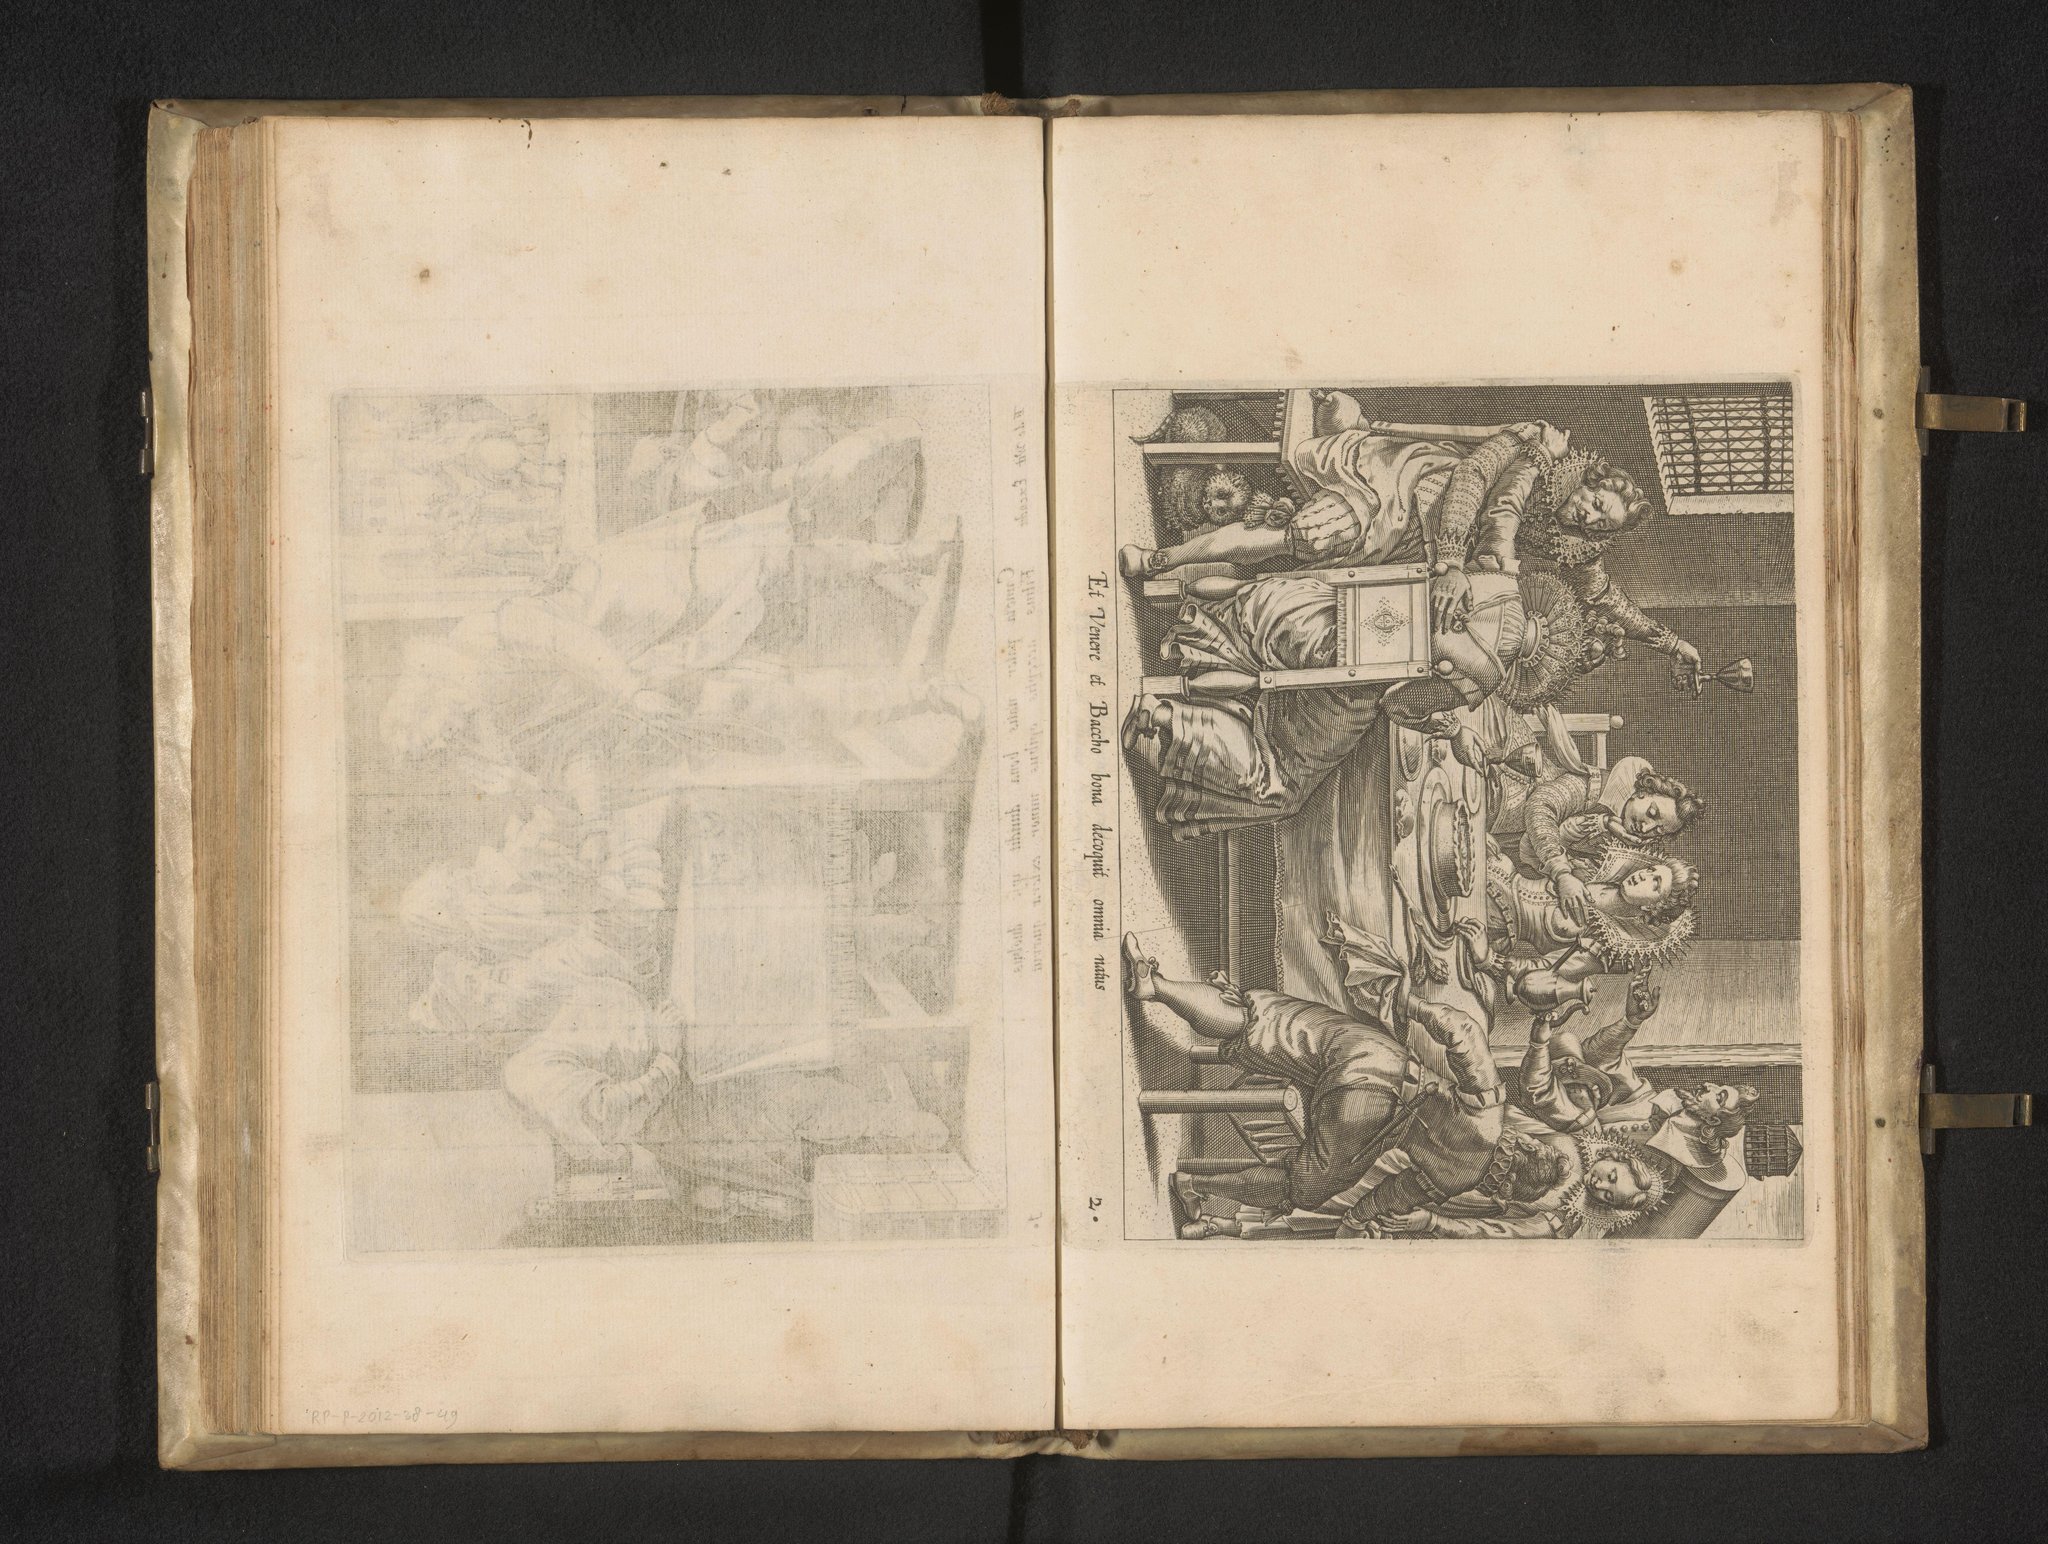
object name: print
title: Het losbandige leven van de verloren zoon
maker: frederik de wit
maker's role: print maker, printer, publisher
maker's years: 1629-1706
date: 1648-1706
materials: paper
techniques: engraving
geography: amsterdam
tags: the prodigal son in the midst of prostitutes feasting and dissipating his patrimony, usually in a brothel or inn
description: Het losbandige leven van de verloren zoon. Onderdeel van een serie van 4 prenten van het verhaal van de Verloren Zoon. Genummerd rechtsonder: 2. In de marge een regel tekst in Latijn. Onderdeel van een album met voornamelijk christelijke voorstellingen.